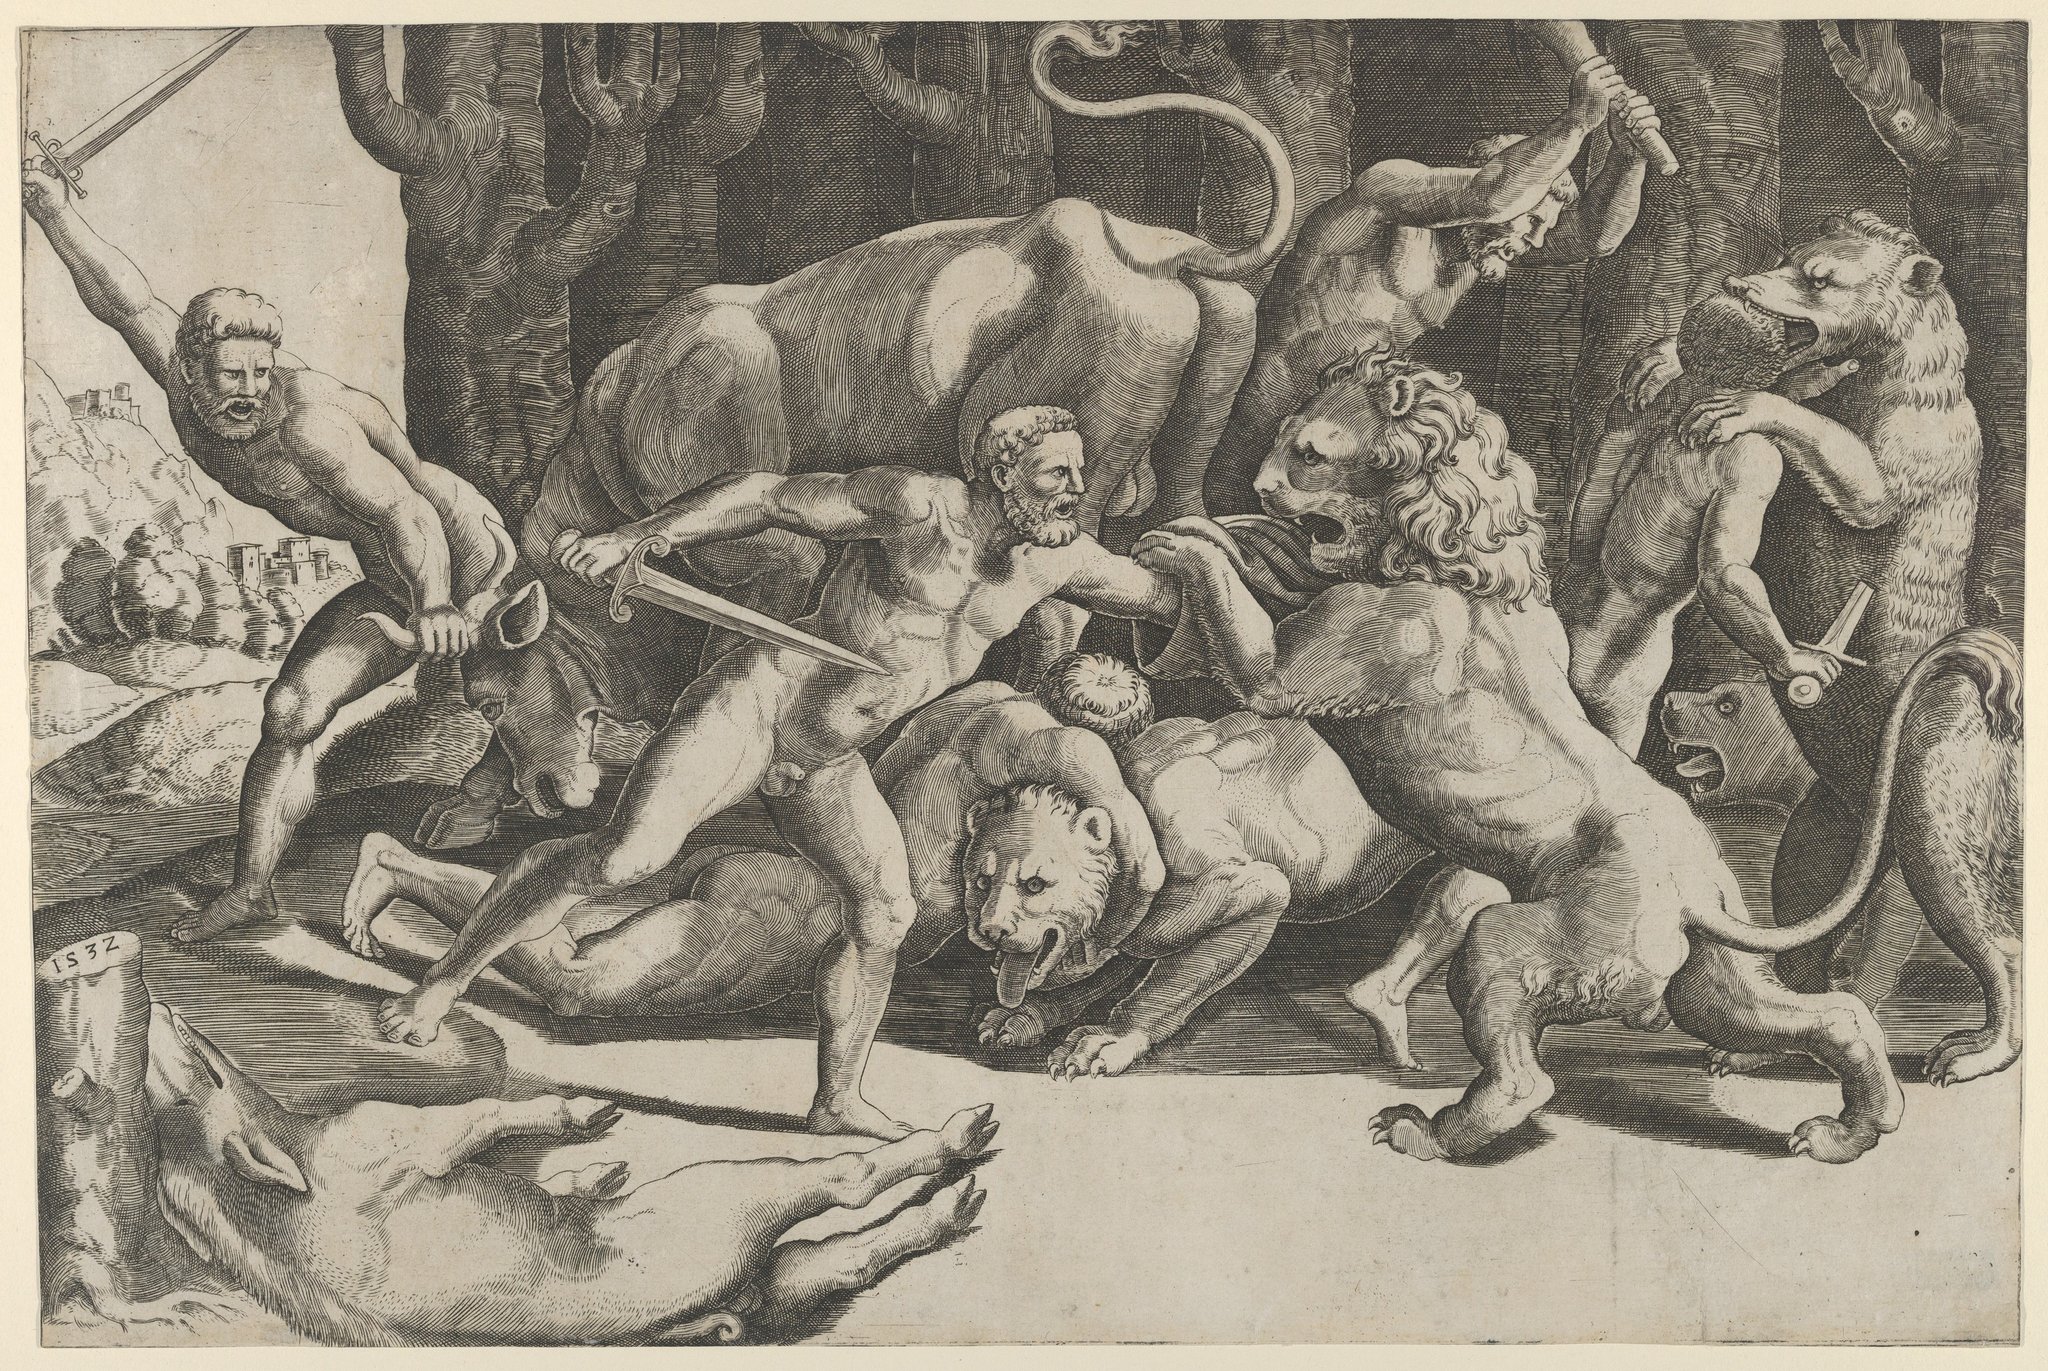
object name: print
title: Five men fighting beasts, at lower left is a fallen boar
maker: master of the die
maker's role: artist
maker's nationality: italian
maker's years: 1525-1560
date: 1532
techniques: engraving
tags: swords,male nudes,boars,lions